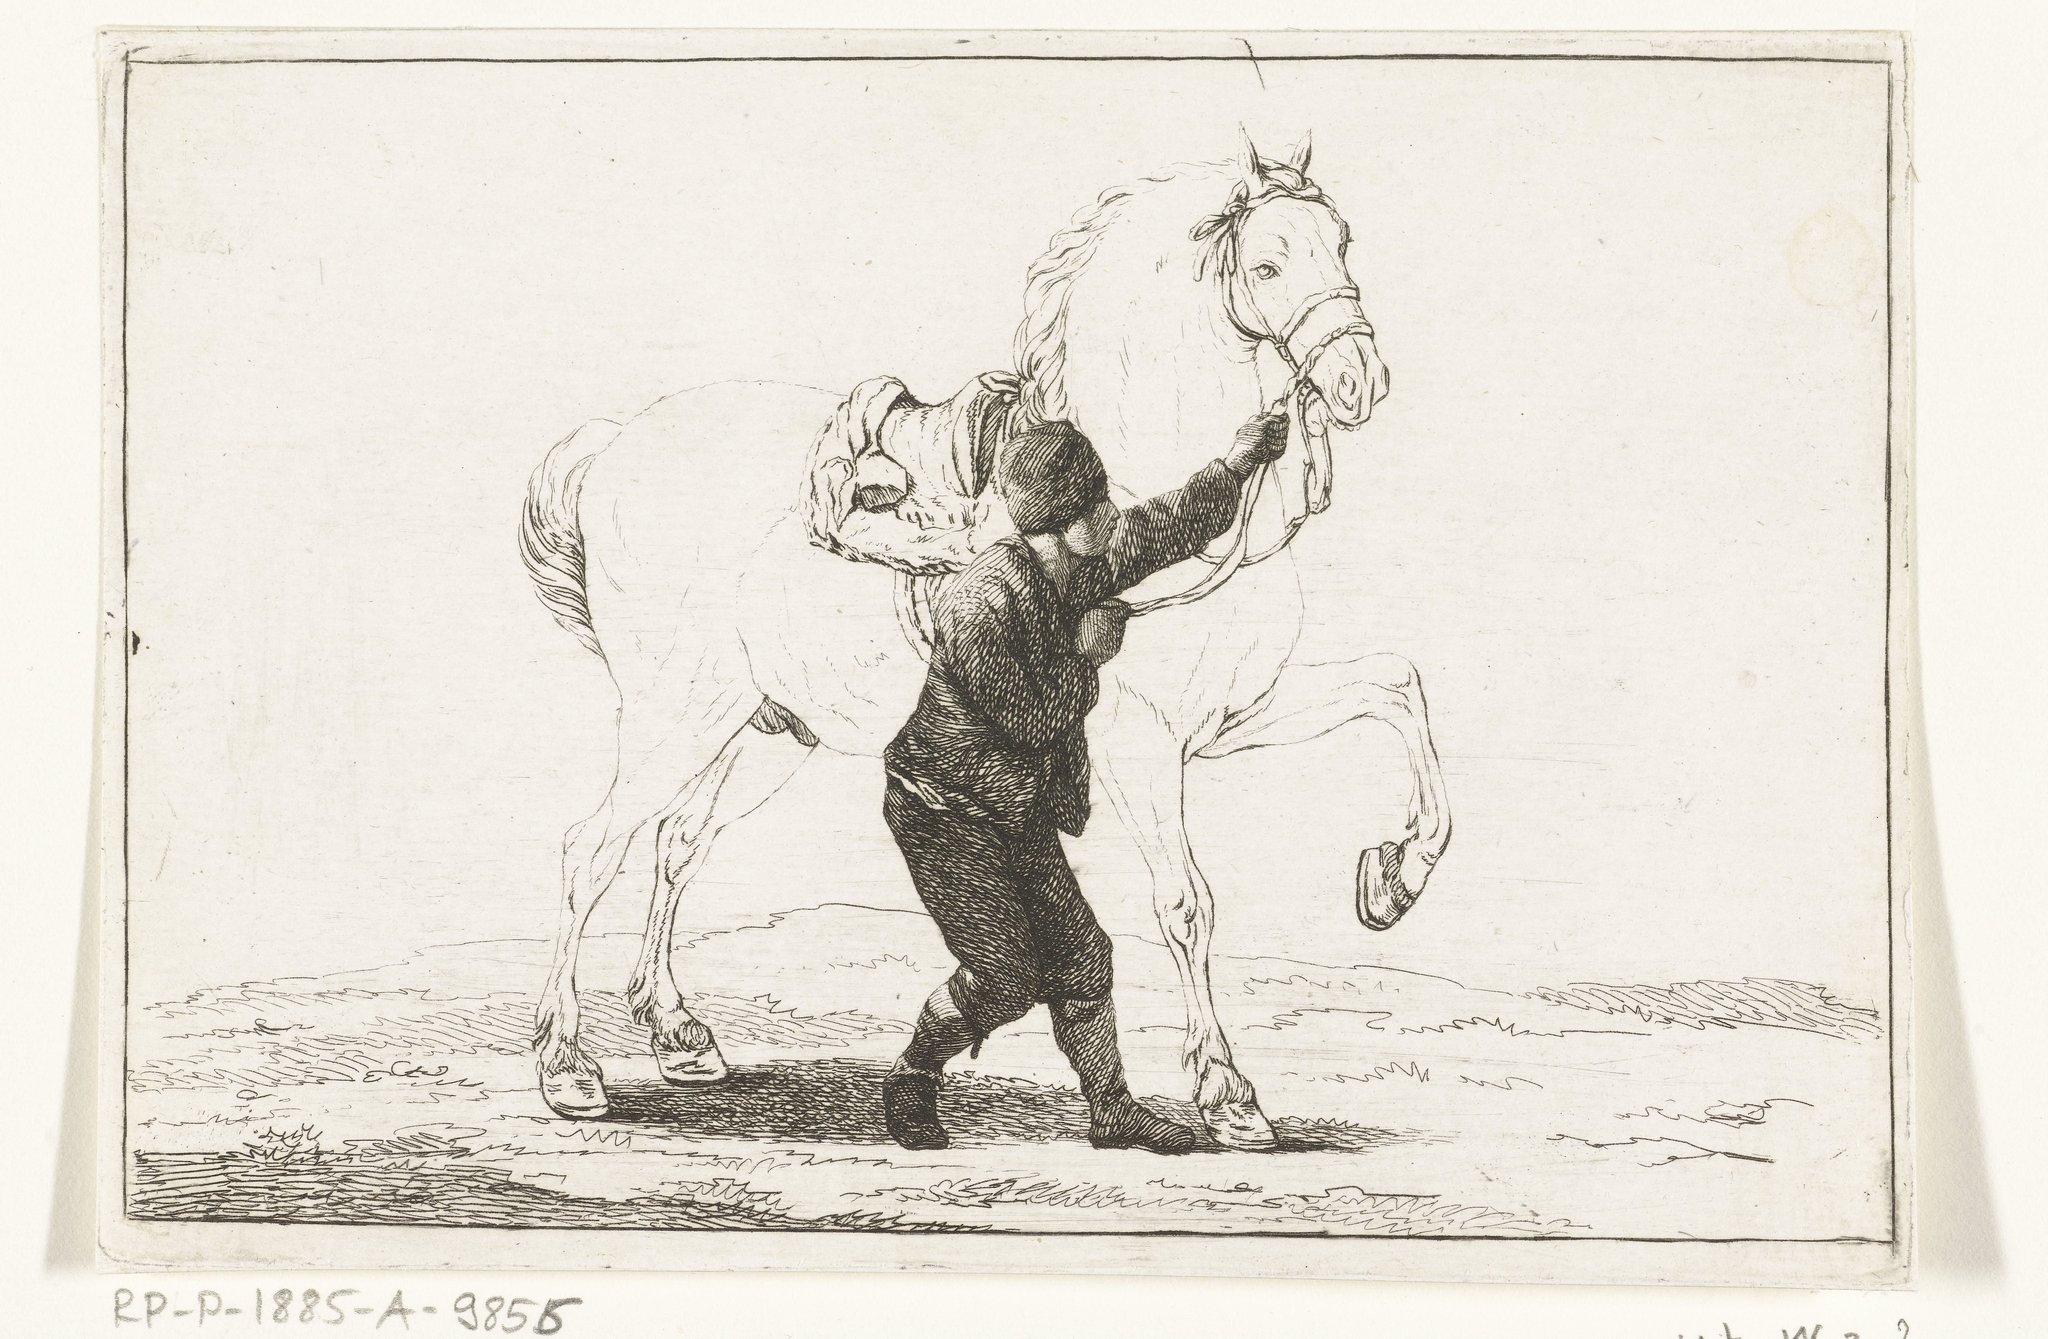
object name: print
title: Een jongen houdt een paard aan de toom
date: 1800-1841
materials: paper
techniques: etching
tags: horse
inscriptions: collector's mark: Lugt 2228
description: Een jongen houdt een paard aan de toom. Het paard is alleen in omtrek weergegeven.